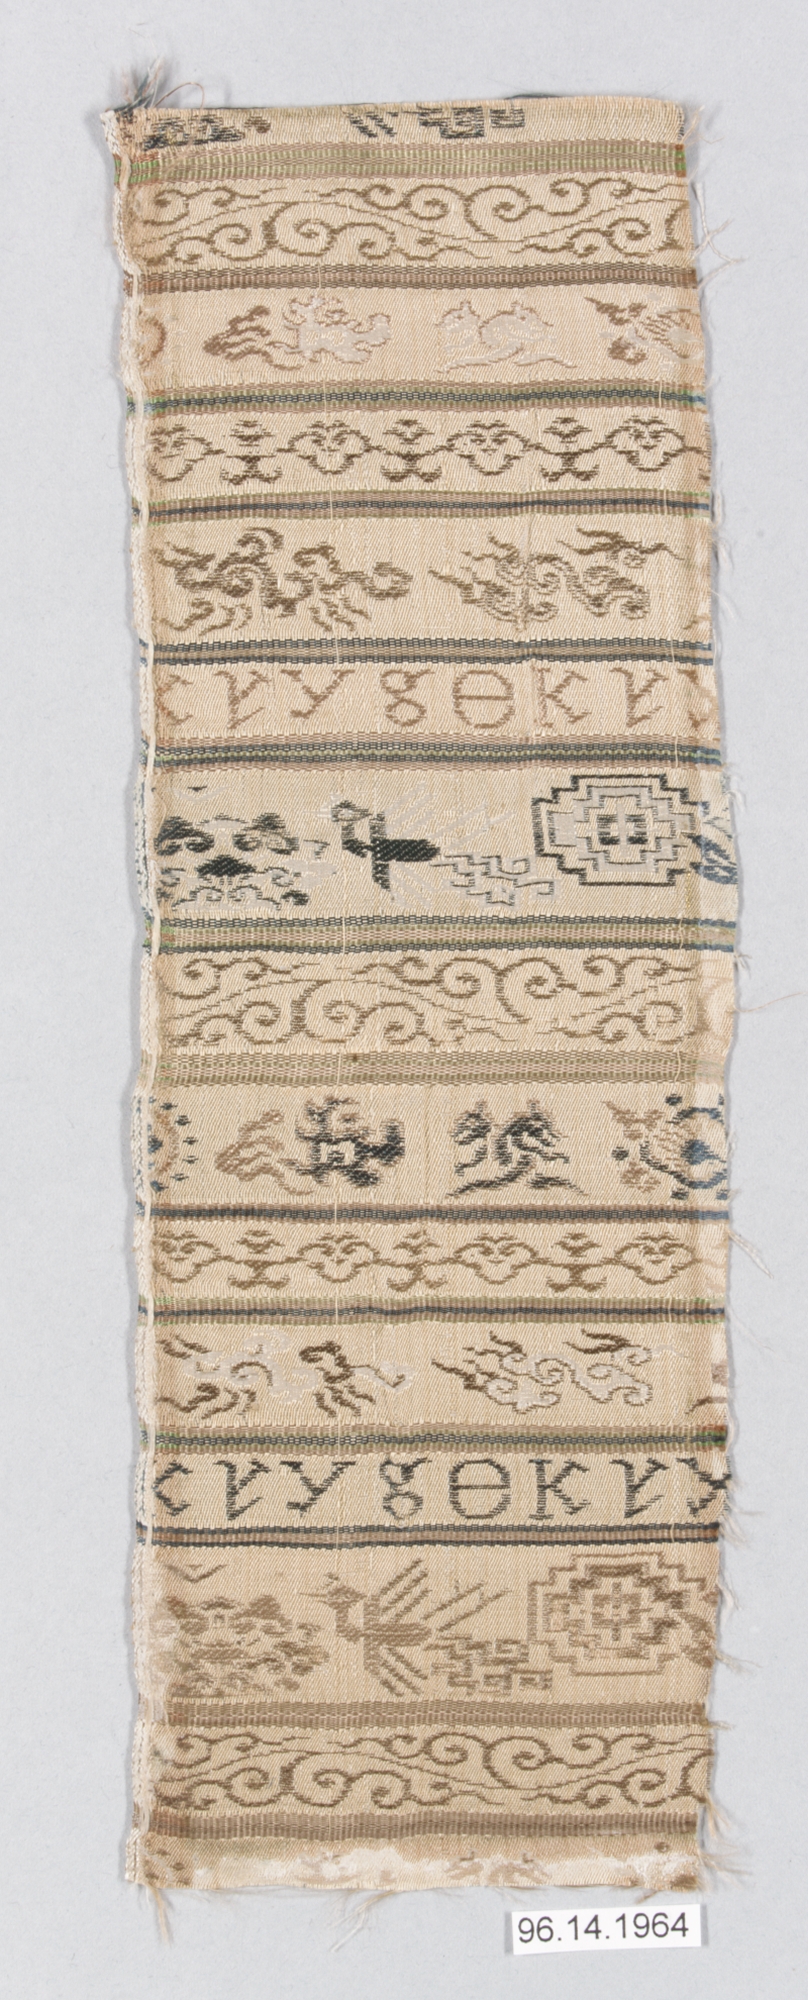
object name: piece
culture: japanese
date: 1701-1900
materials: silk